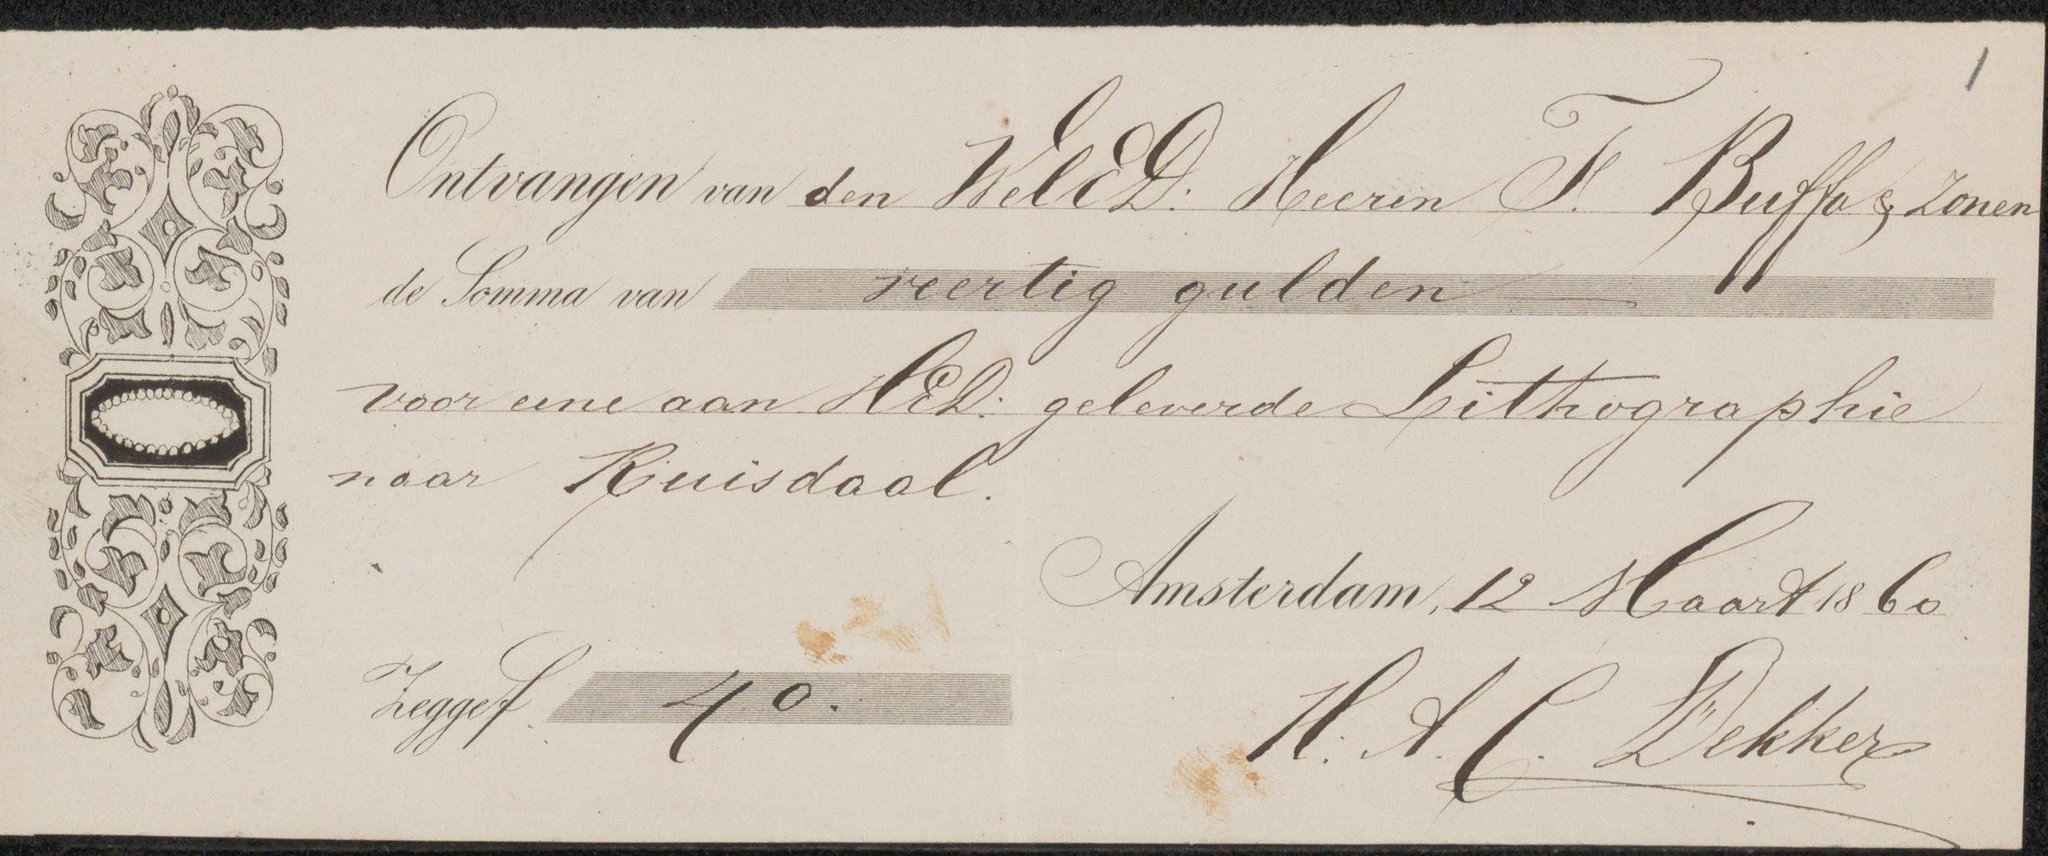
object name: ontvangstbewijs, kwitantie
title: Kwitantie voor Hendrik Adriaan Christiaan Dekker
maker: hendrik adriaan christiaan dekker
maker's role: draughtsman, print maker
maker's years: 1836-1905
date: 1860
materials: ink, paper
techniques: pen, printing, writing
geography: amsterdam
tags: amsterdam, painter, print maker, draughtsman, jacob isaacksz van ruisdael, the graphic arts, money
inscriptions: collector's mark: Lugt 2233